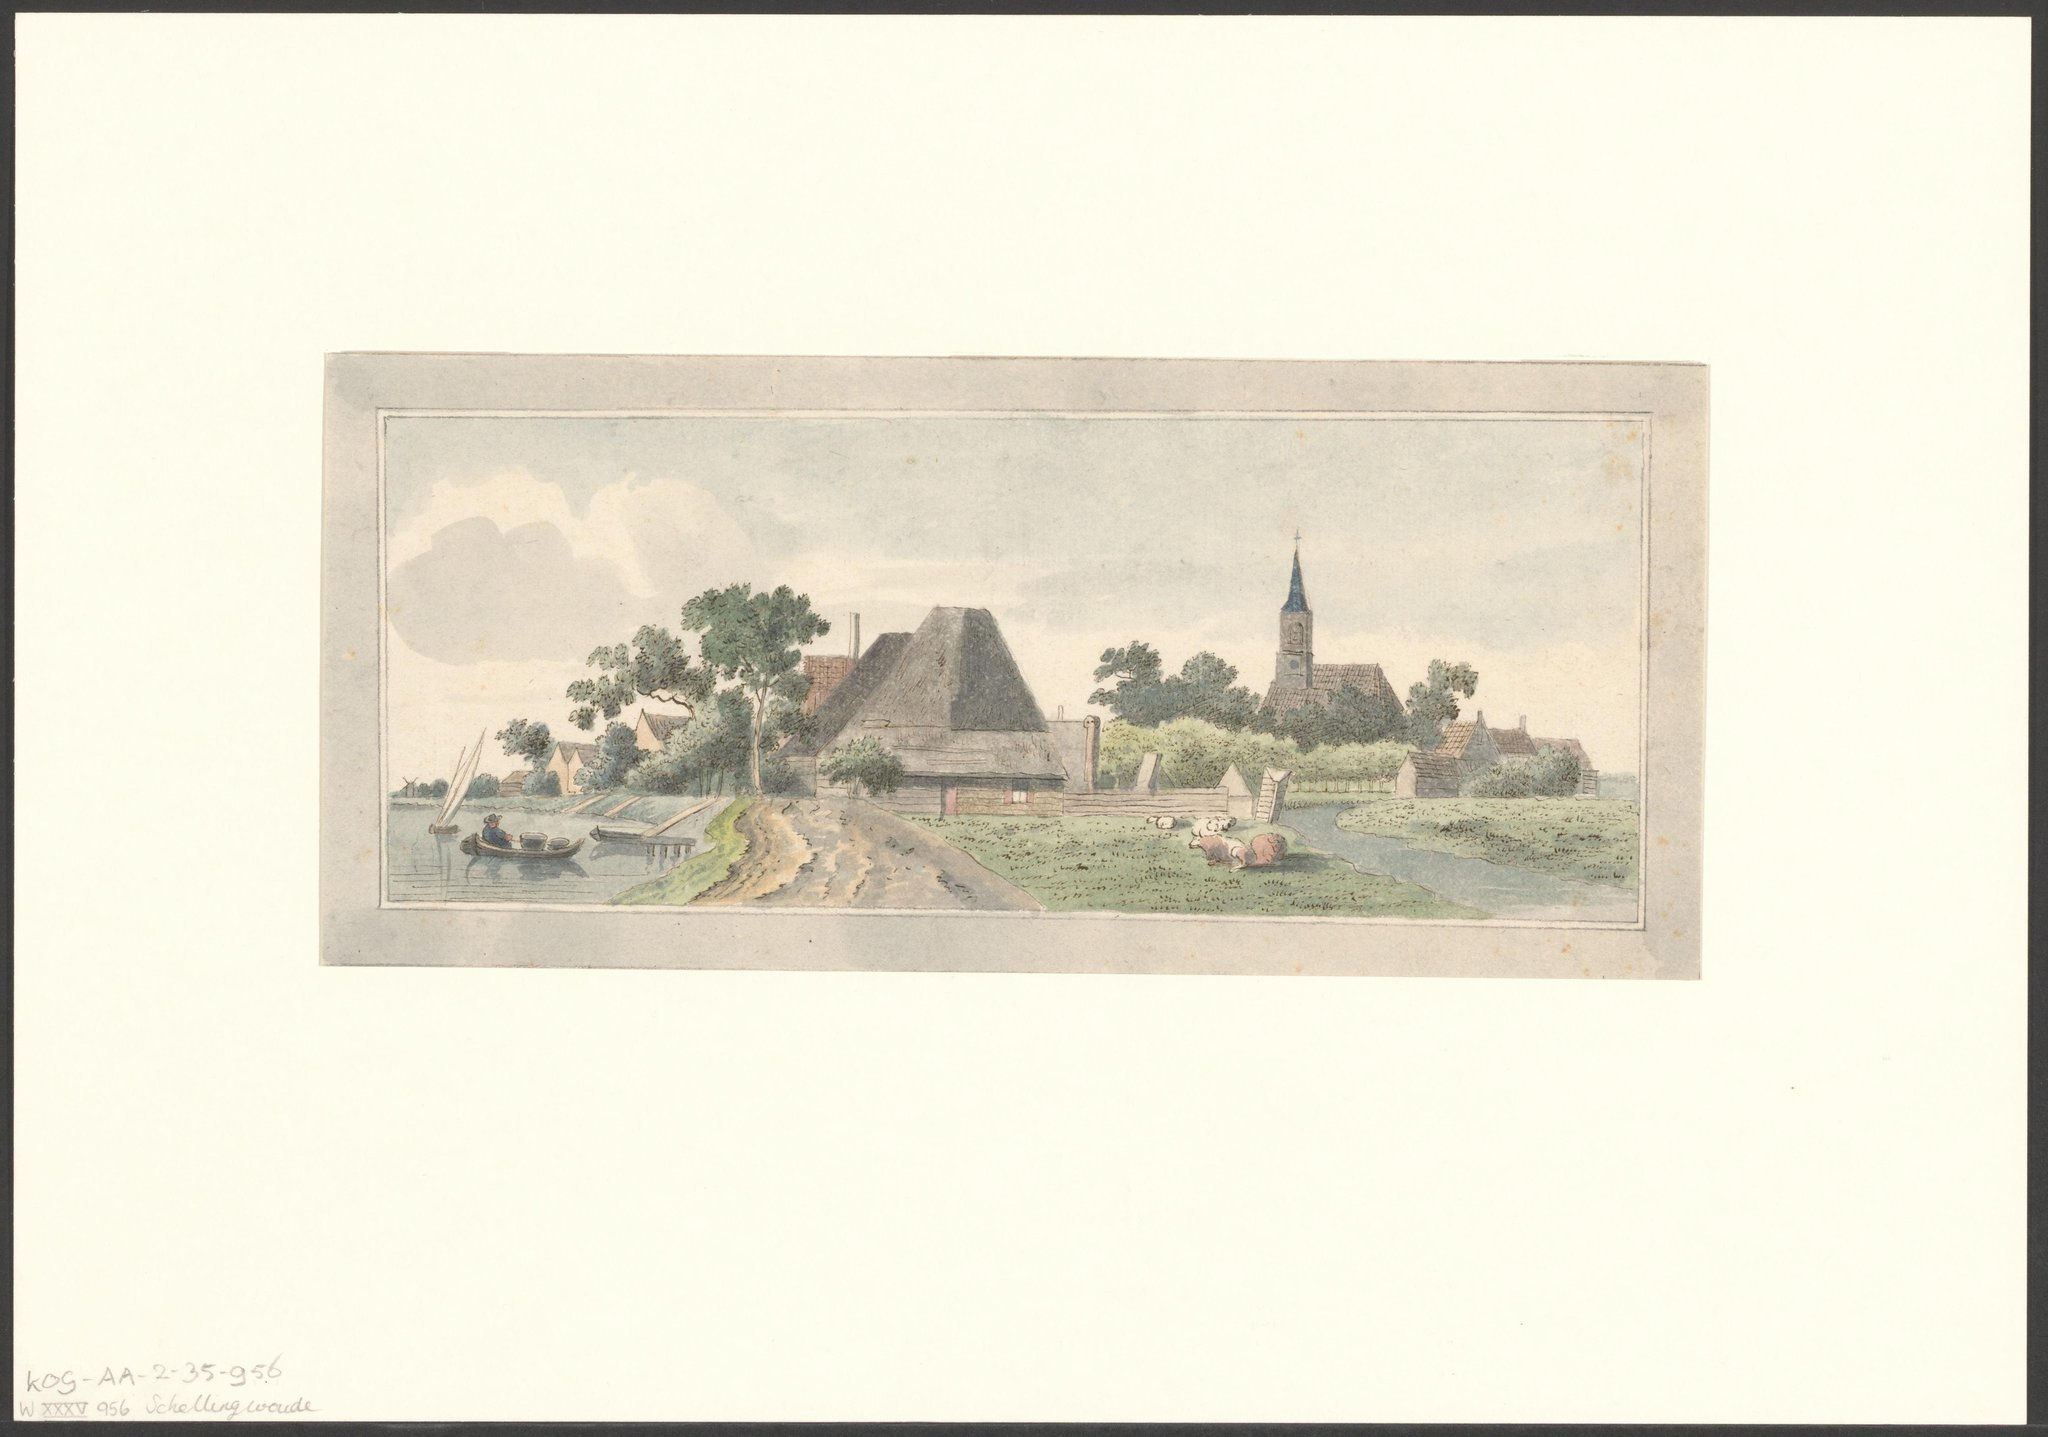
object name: drawing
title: Gezicht op Schellingwoude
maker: hendrik tavenier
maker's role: draughtsman, print maker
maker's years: 1734-1807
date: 1793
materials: ink, paper, pencil, watercolor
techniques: brush, pen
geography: amsterdam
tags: sailing-ship, sailing-boat, canal, village, road, path, parts of church exterior and annexes: spire, the usual house or row of houses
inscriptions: inscription: ‘SchellingWou 1793 / HTavenier’, collector's mark: Lugt 800a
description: Tekening binnen de Atlas Van Eck ingedeeld op wijknummer 35.